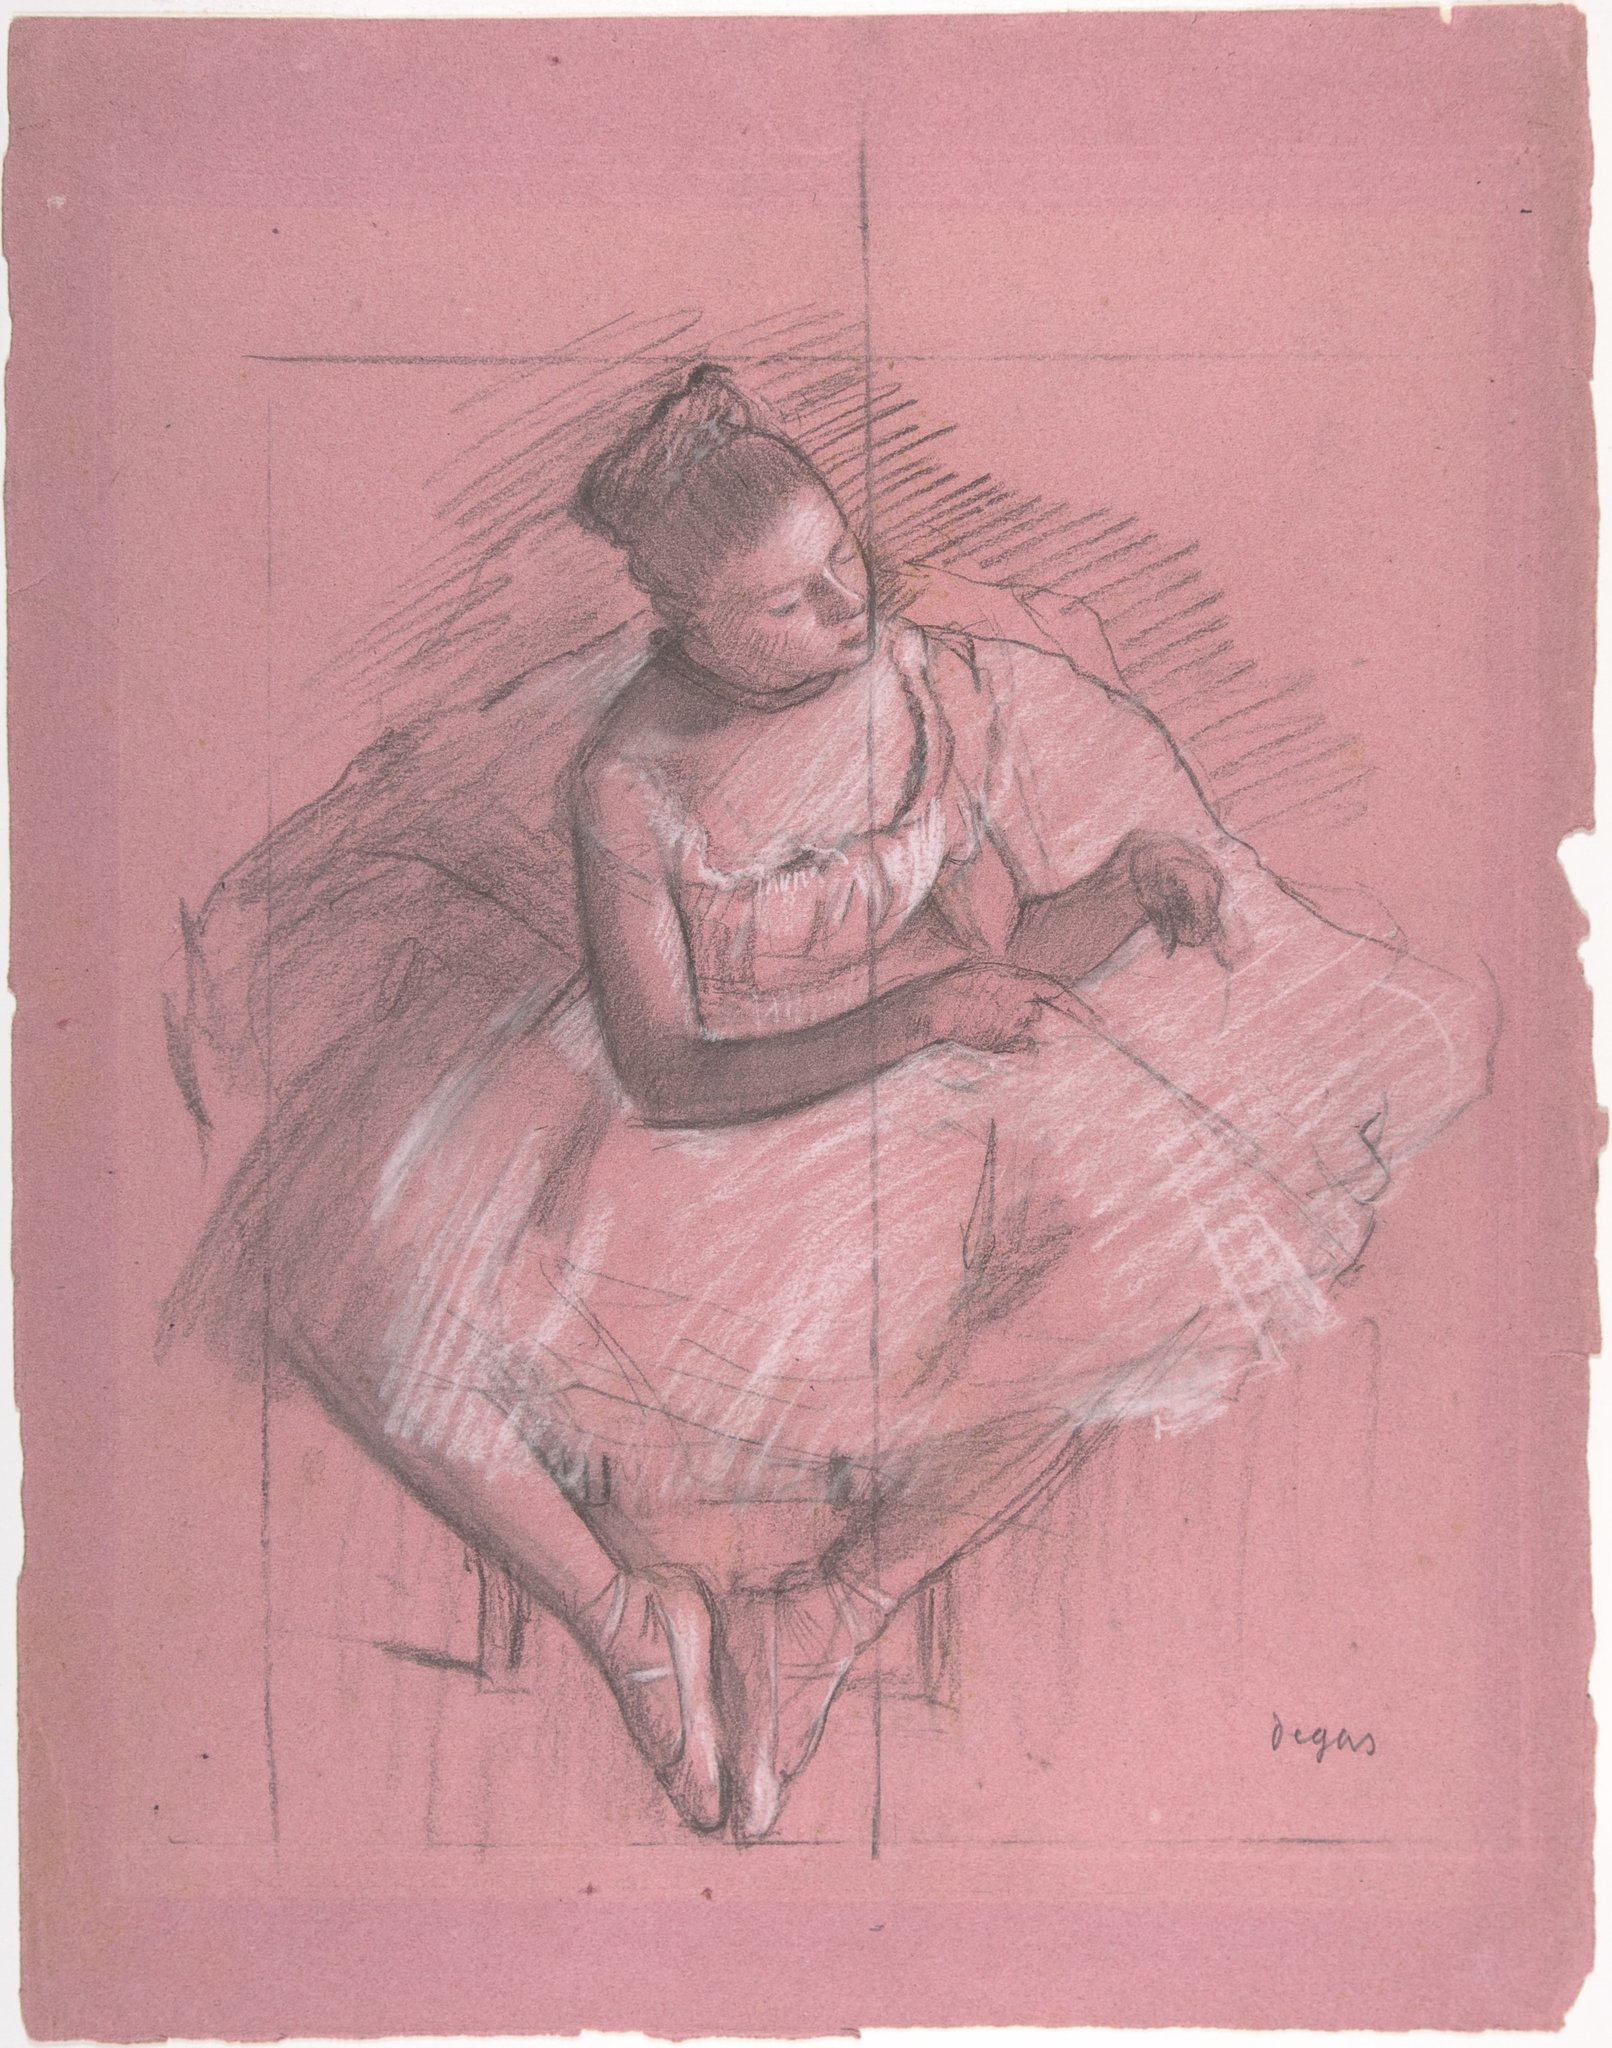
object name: drawing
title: Seated Dancer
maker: edgar degas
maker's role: artist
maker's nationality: french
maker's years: 1834-1917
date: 1873-1874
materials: charcoal, graphite, paper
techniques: heightening, drawing, transfer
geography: france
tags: women,dancers,ballet